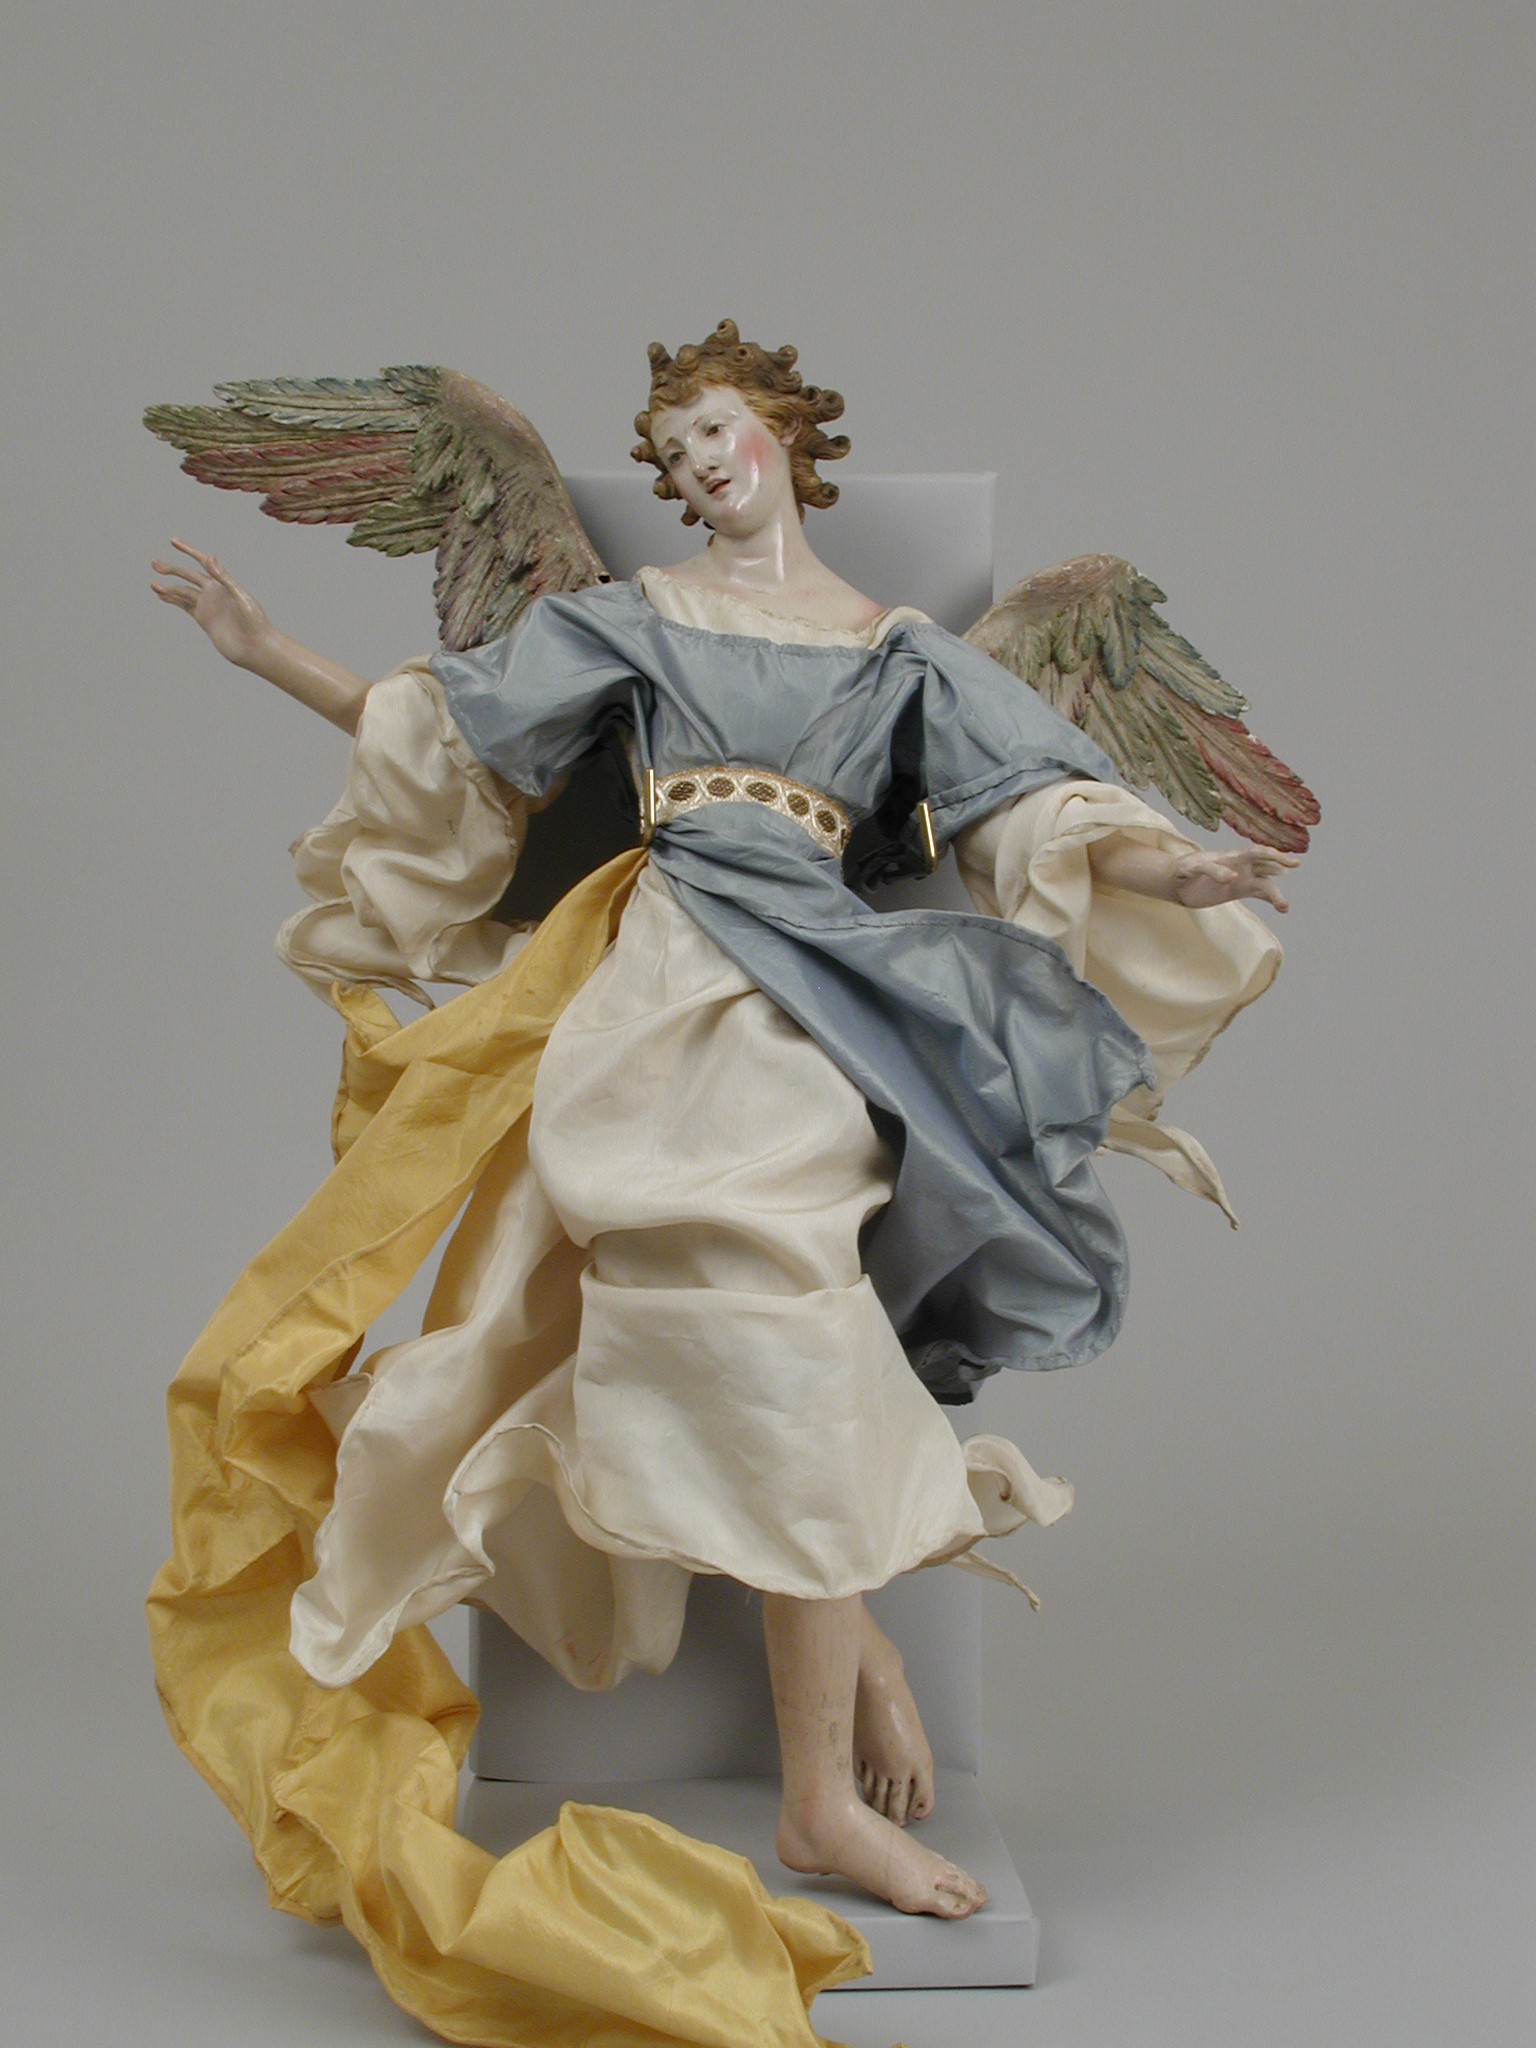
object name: crèche figure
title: Angel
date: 1767-1833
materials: silk, terracotta, wood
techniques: polychrome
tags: angels